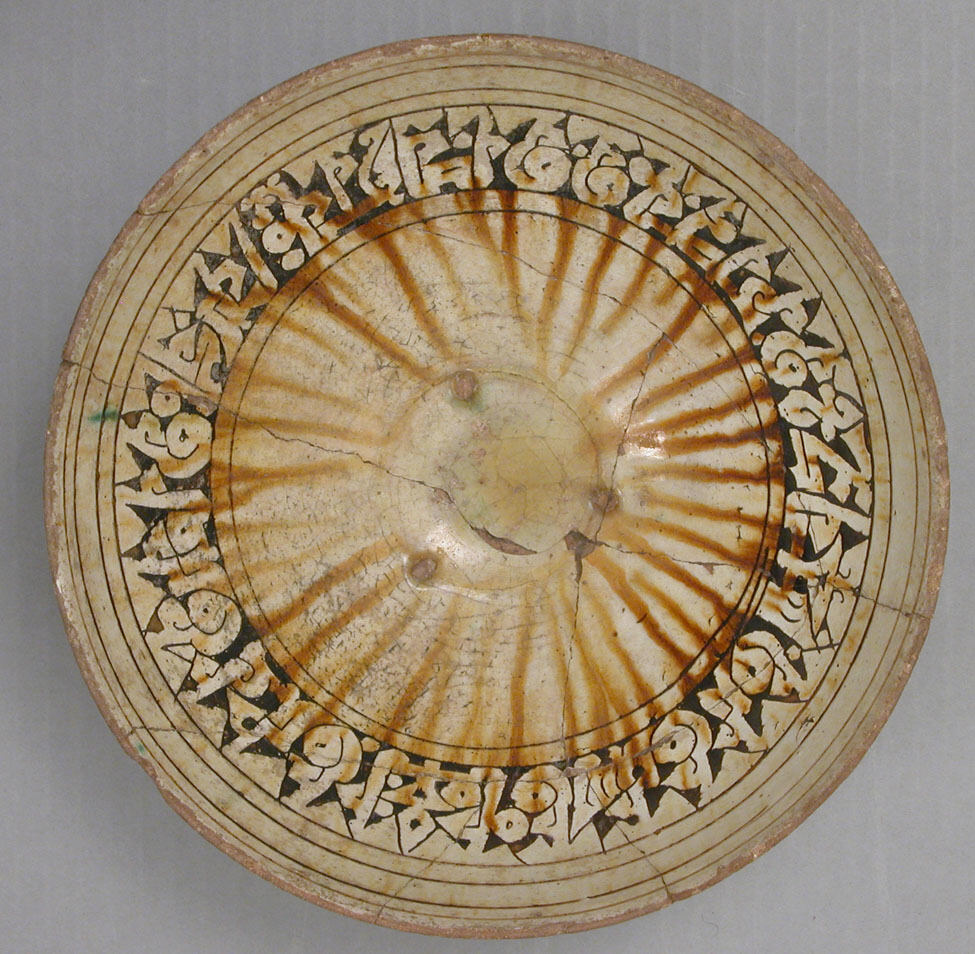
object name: bowl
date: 801-1100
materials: earthenware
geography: iran